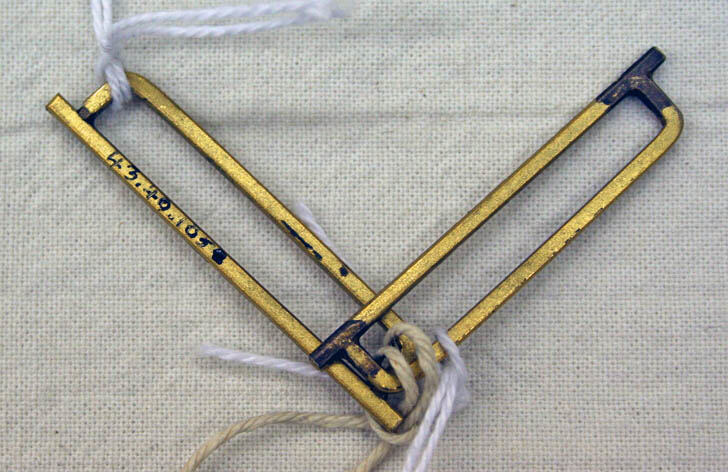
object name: belt buckle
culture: american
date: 1890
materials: metal